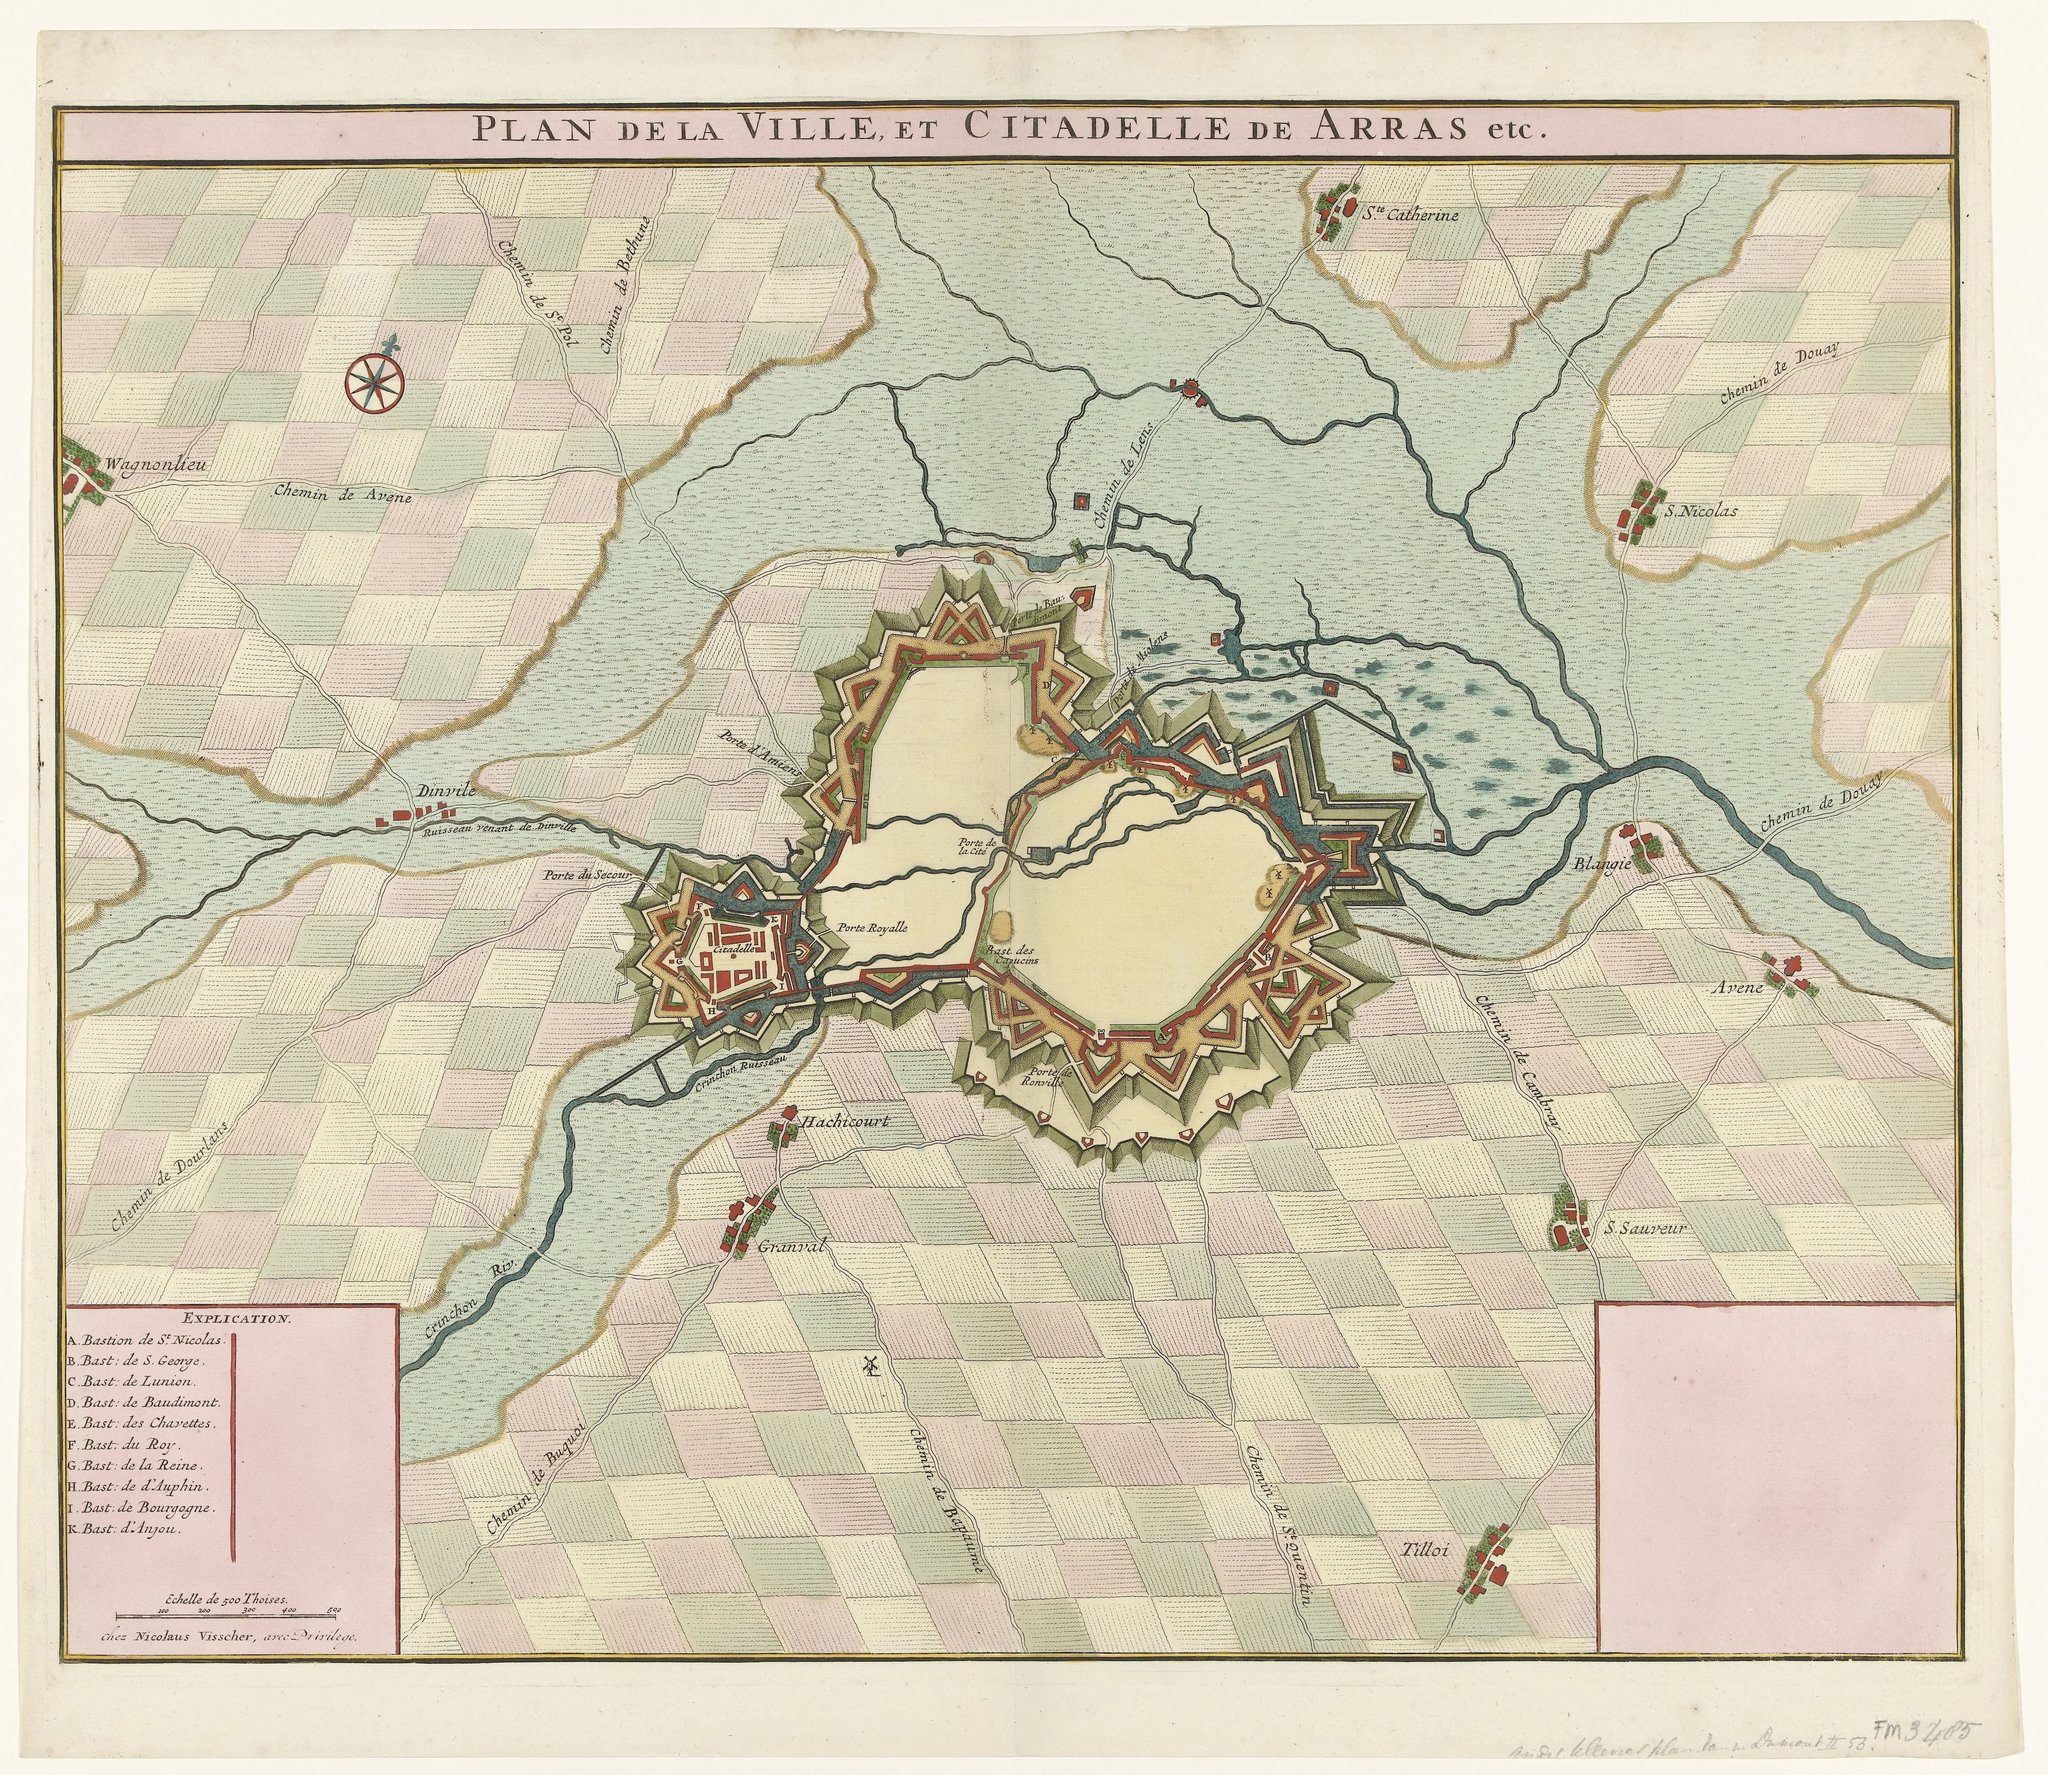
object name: print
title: Kaart van Arras, 1712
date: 1712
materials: paper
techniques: etching, hand coloring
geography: northern netherlands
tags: fortress, maps of cities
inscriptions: collector's mark: Lugt 2228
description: Plattegrond van de versterkingen om de stad Arras (Atrecht), belegerd door de Geallieerden in maart 1712. Linksonder een cartouche met de legenda A-K in het Frans.